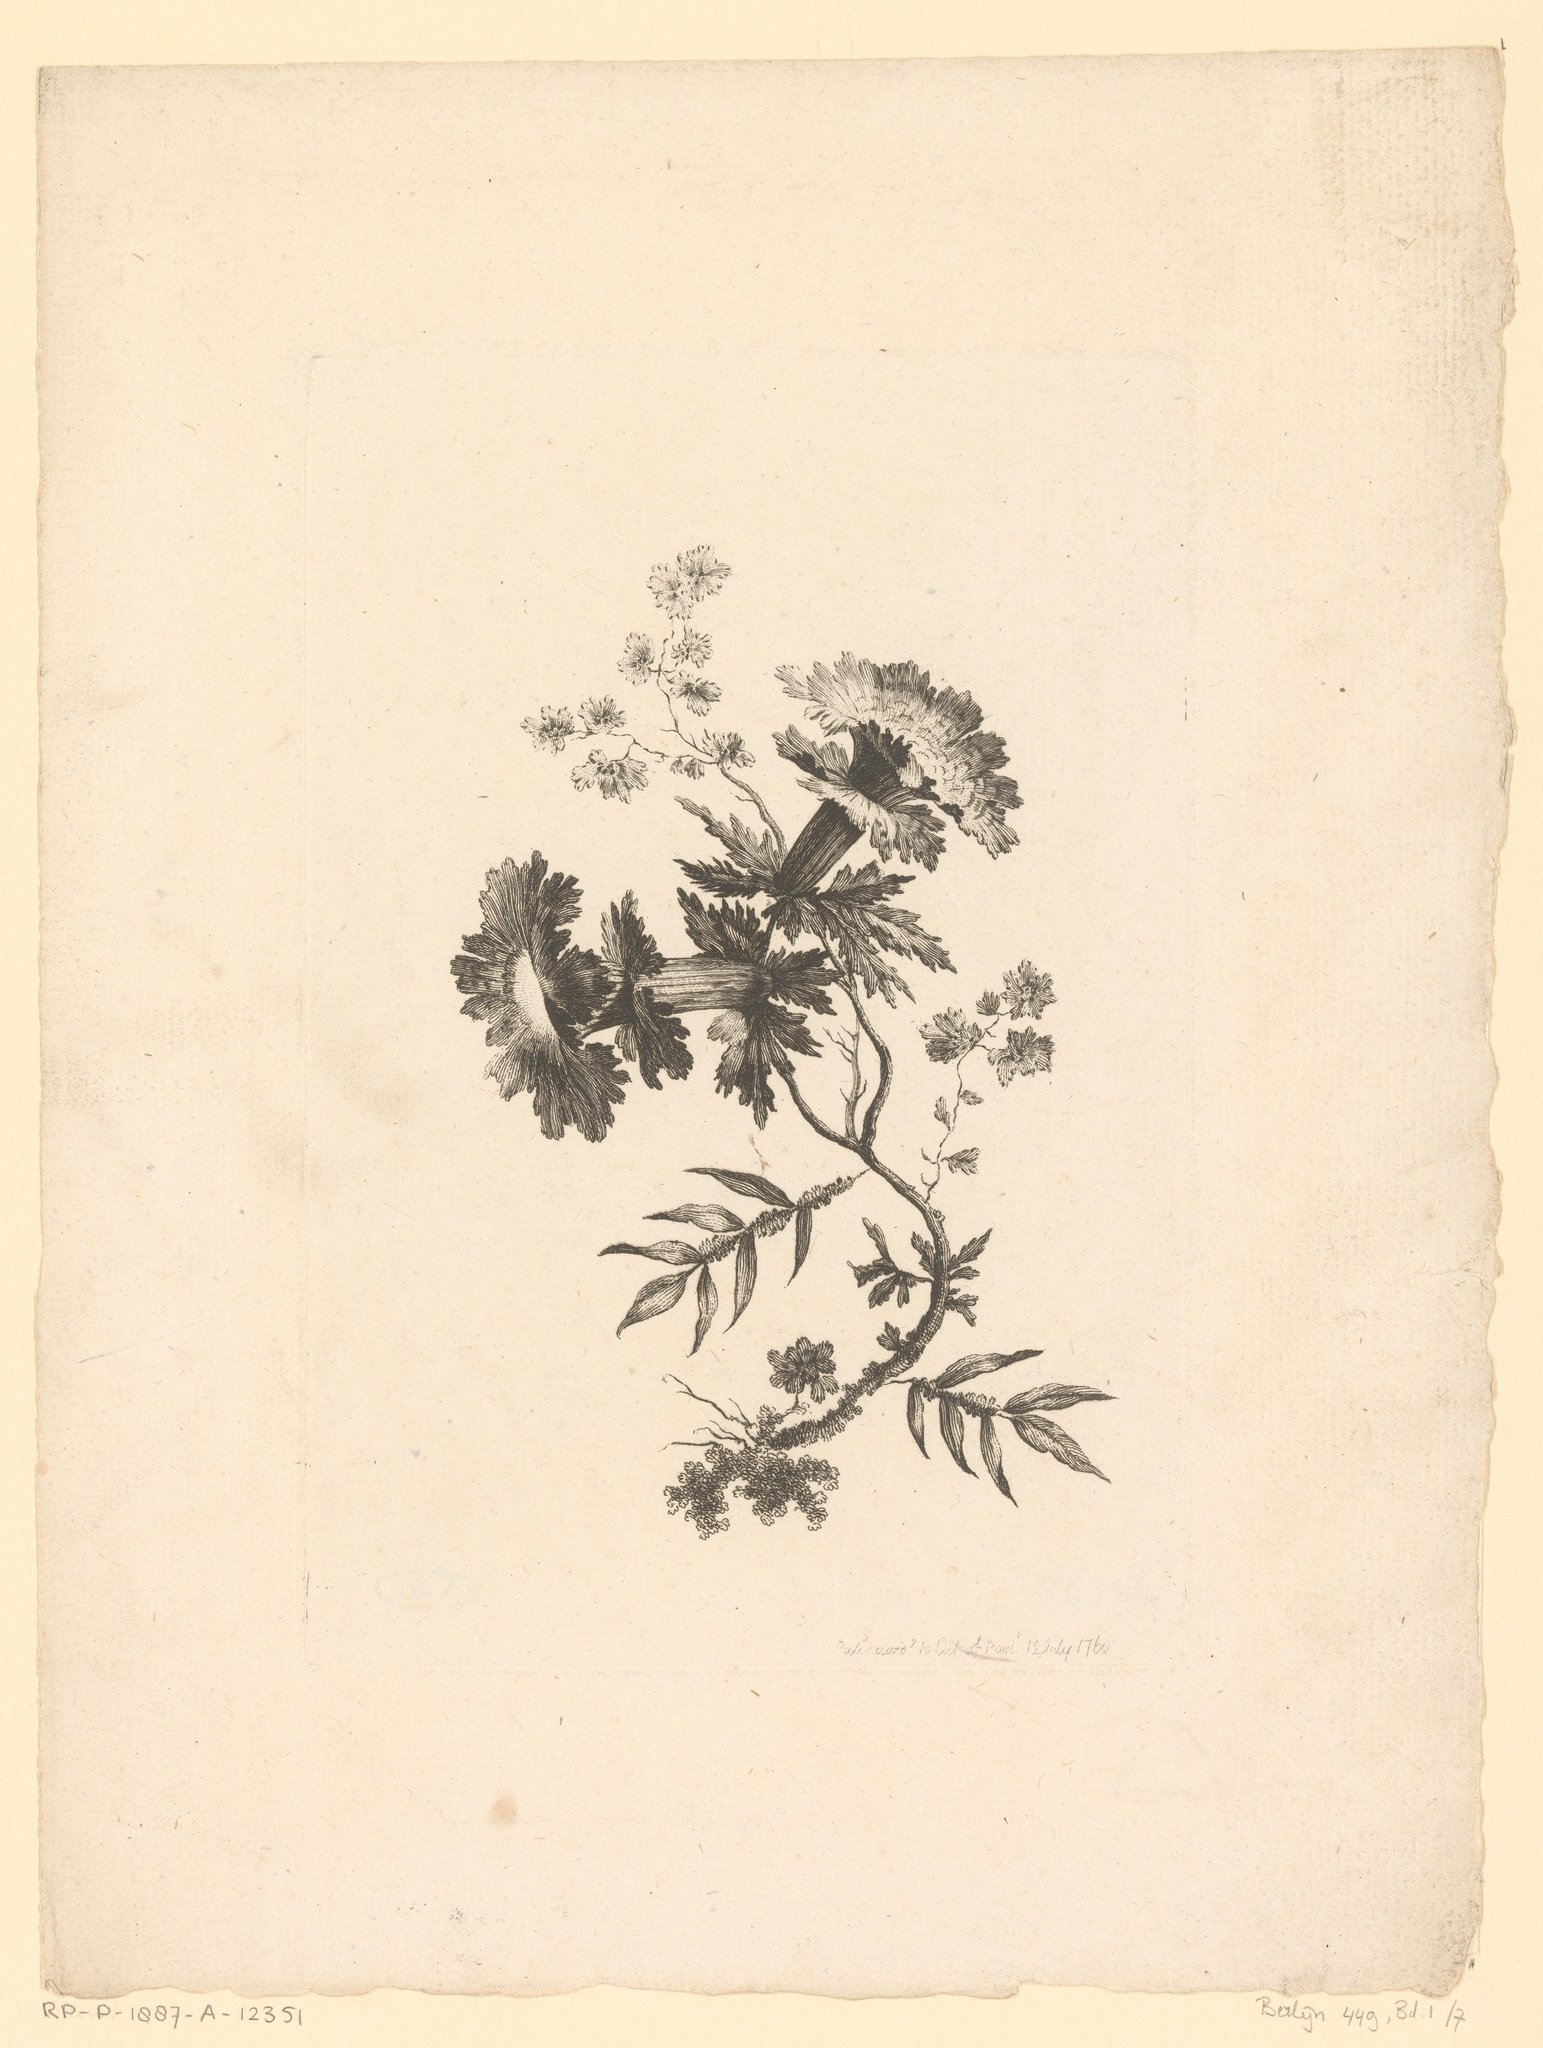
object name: print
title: Trompetbloemen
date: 1760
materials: paper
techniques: etching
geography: london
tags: flowers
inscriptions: collector's mark: Lugt 2228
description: Prent mogelijk onderdeel van serie Recoeil de fleurs de Caprice.